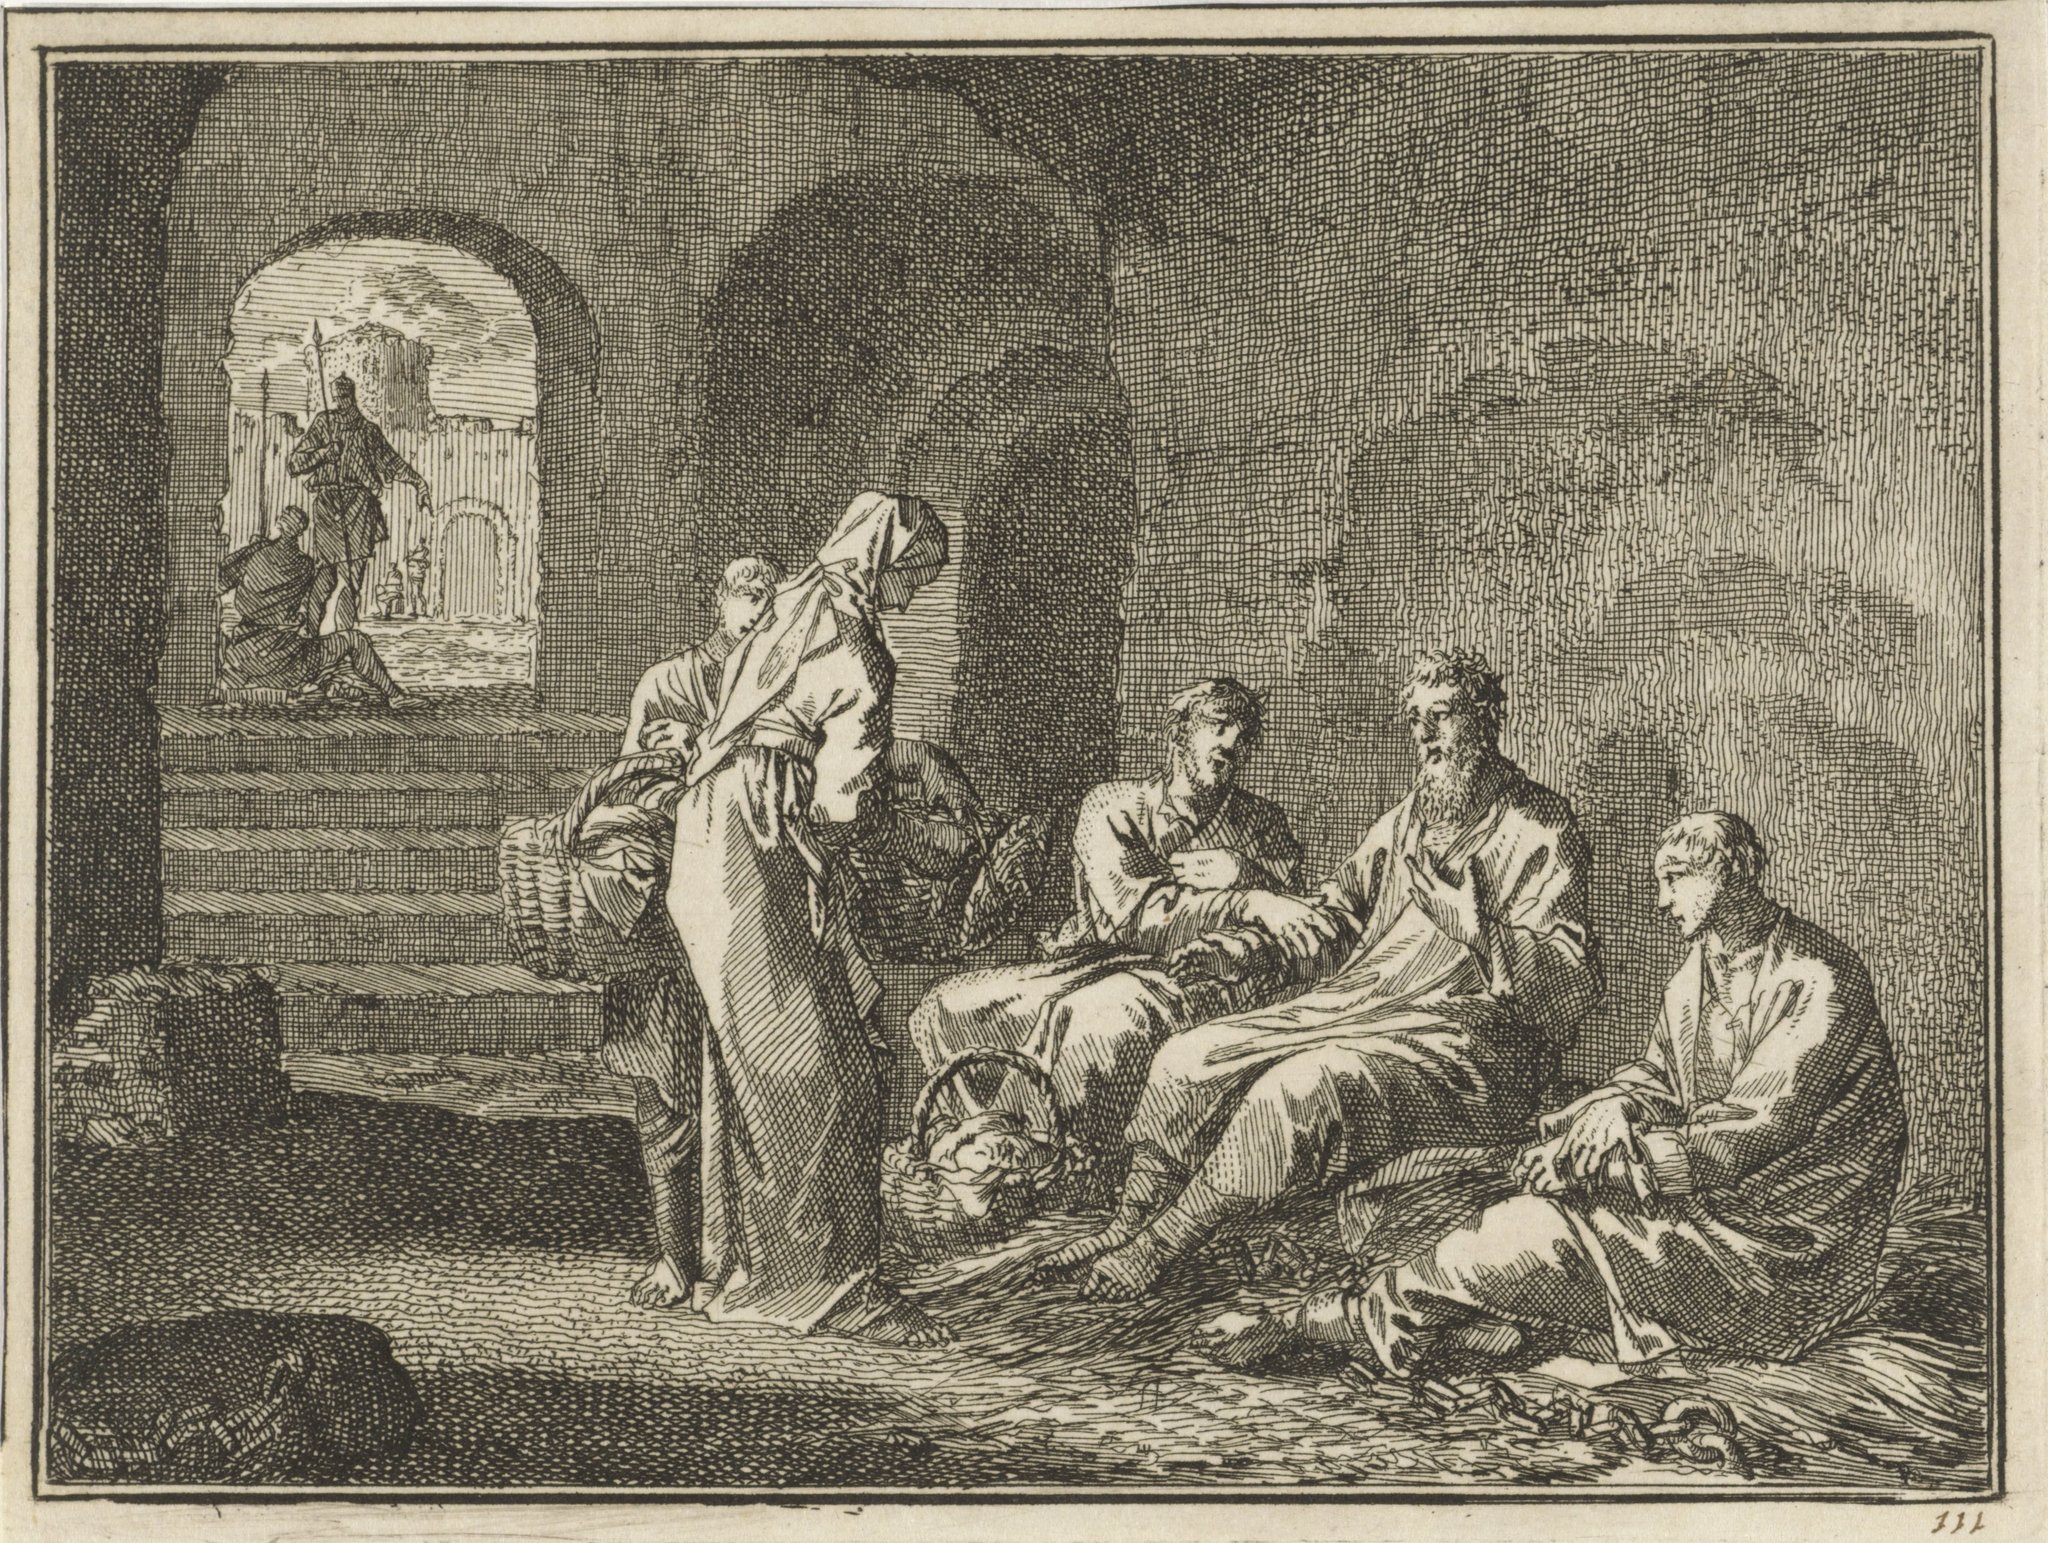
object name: print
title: Gevangenen bezoeken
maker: jan luyken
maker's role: draughtsman, print maker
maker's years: 1649-1712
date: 1712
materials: paper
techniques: etching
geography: amsterdam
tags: visiting or liberating the imprisoned, 'incarceratus solatur' ~ one of the (seven) acts of mercy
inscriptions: number: ‘111’, collector's mark: Lugt 2228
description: Proefdruk van illustratie uit: Luyken, Jan. De schriftuurlyke geschiedenissen en gelykenissen van het Oude en Nieuwe Verbond, 2 delen. Amsterdam: Wed. Pieter Arentsz II en Cornelis van der Sys, 1712, dl. II.